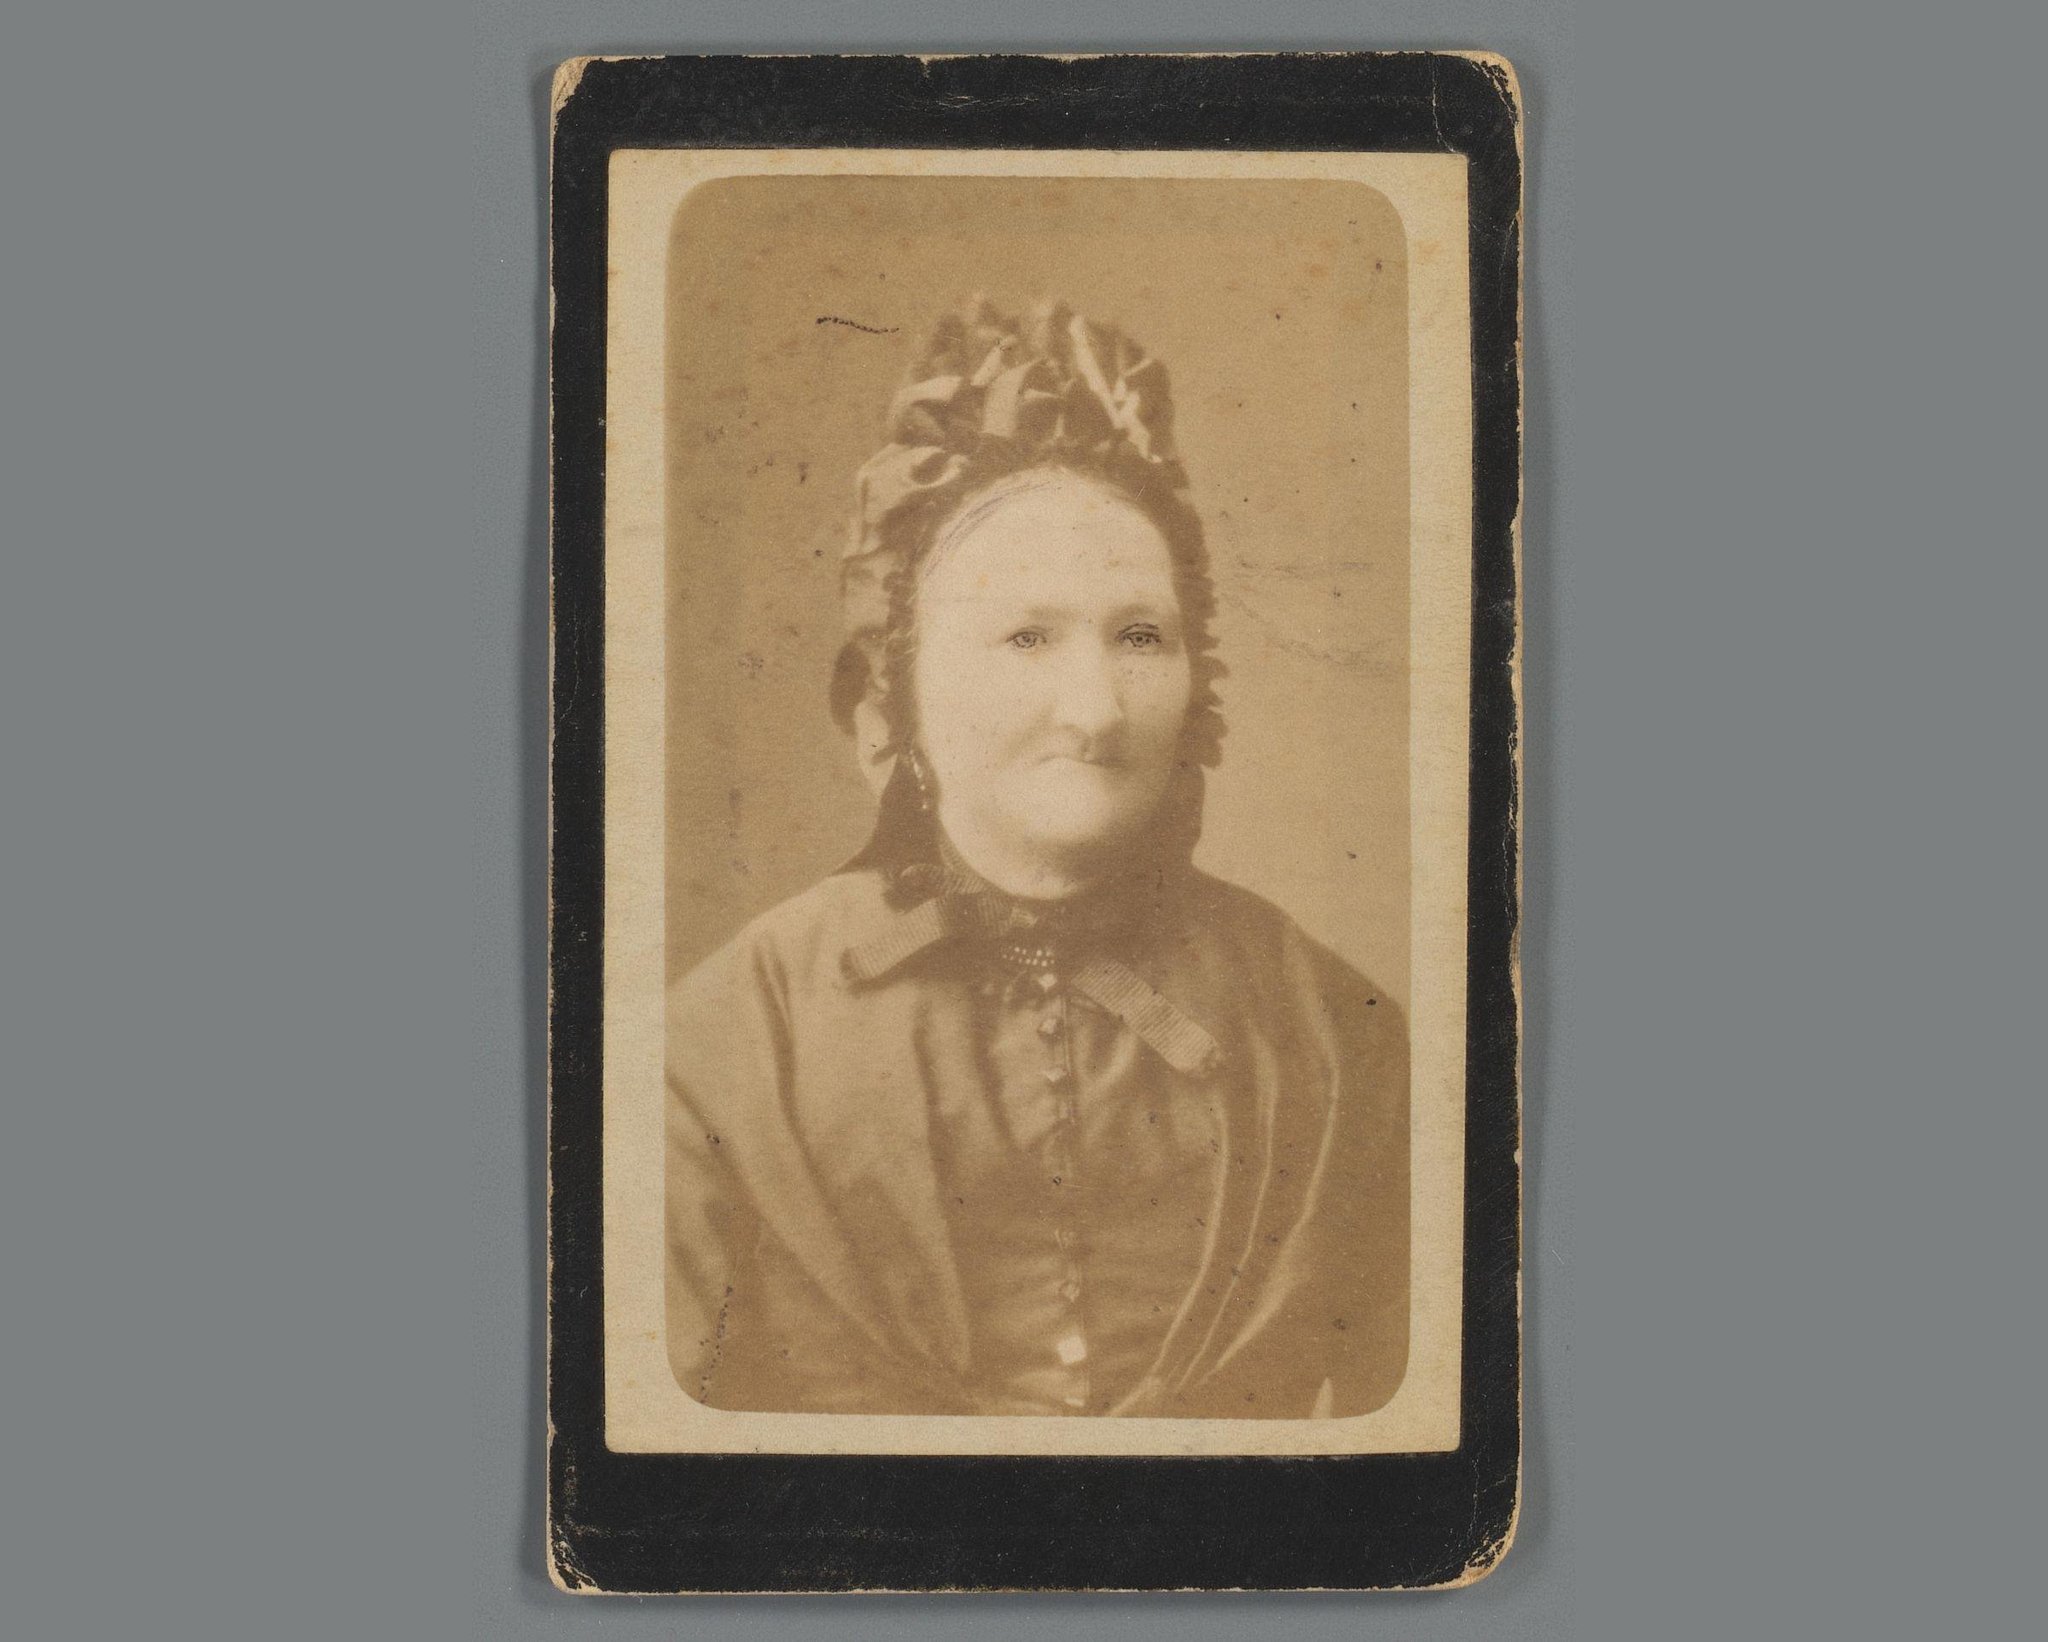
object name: prayer card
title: Portret van Anna Michielsen op bidprent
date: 1889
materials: cardboard, ink, paper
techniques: albumen print, letterpress printing, pen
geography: breda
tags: historical persons, old woman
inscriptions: inscription: ‘Bid voor de Ziel van Zaliger/ Mejuffrouw (...) R.I.P./ J.J. van Turnhout - Breda.’